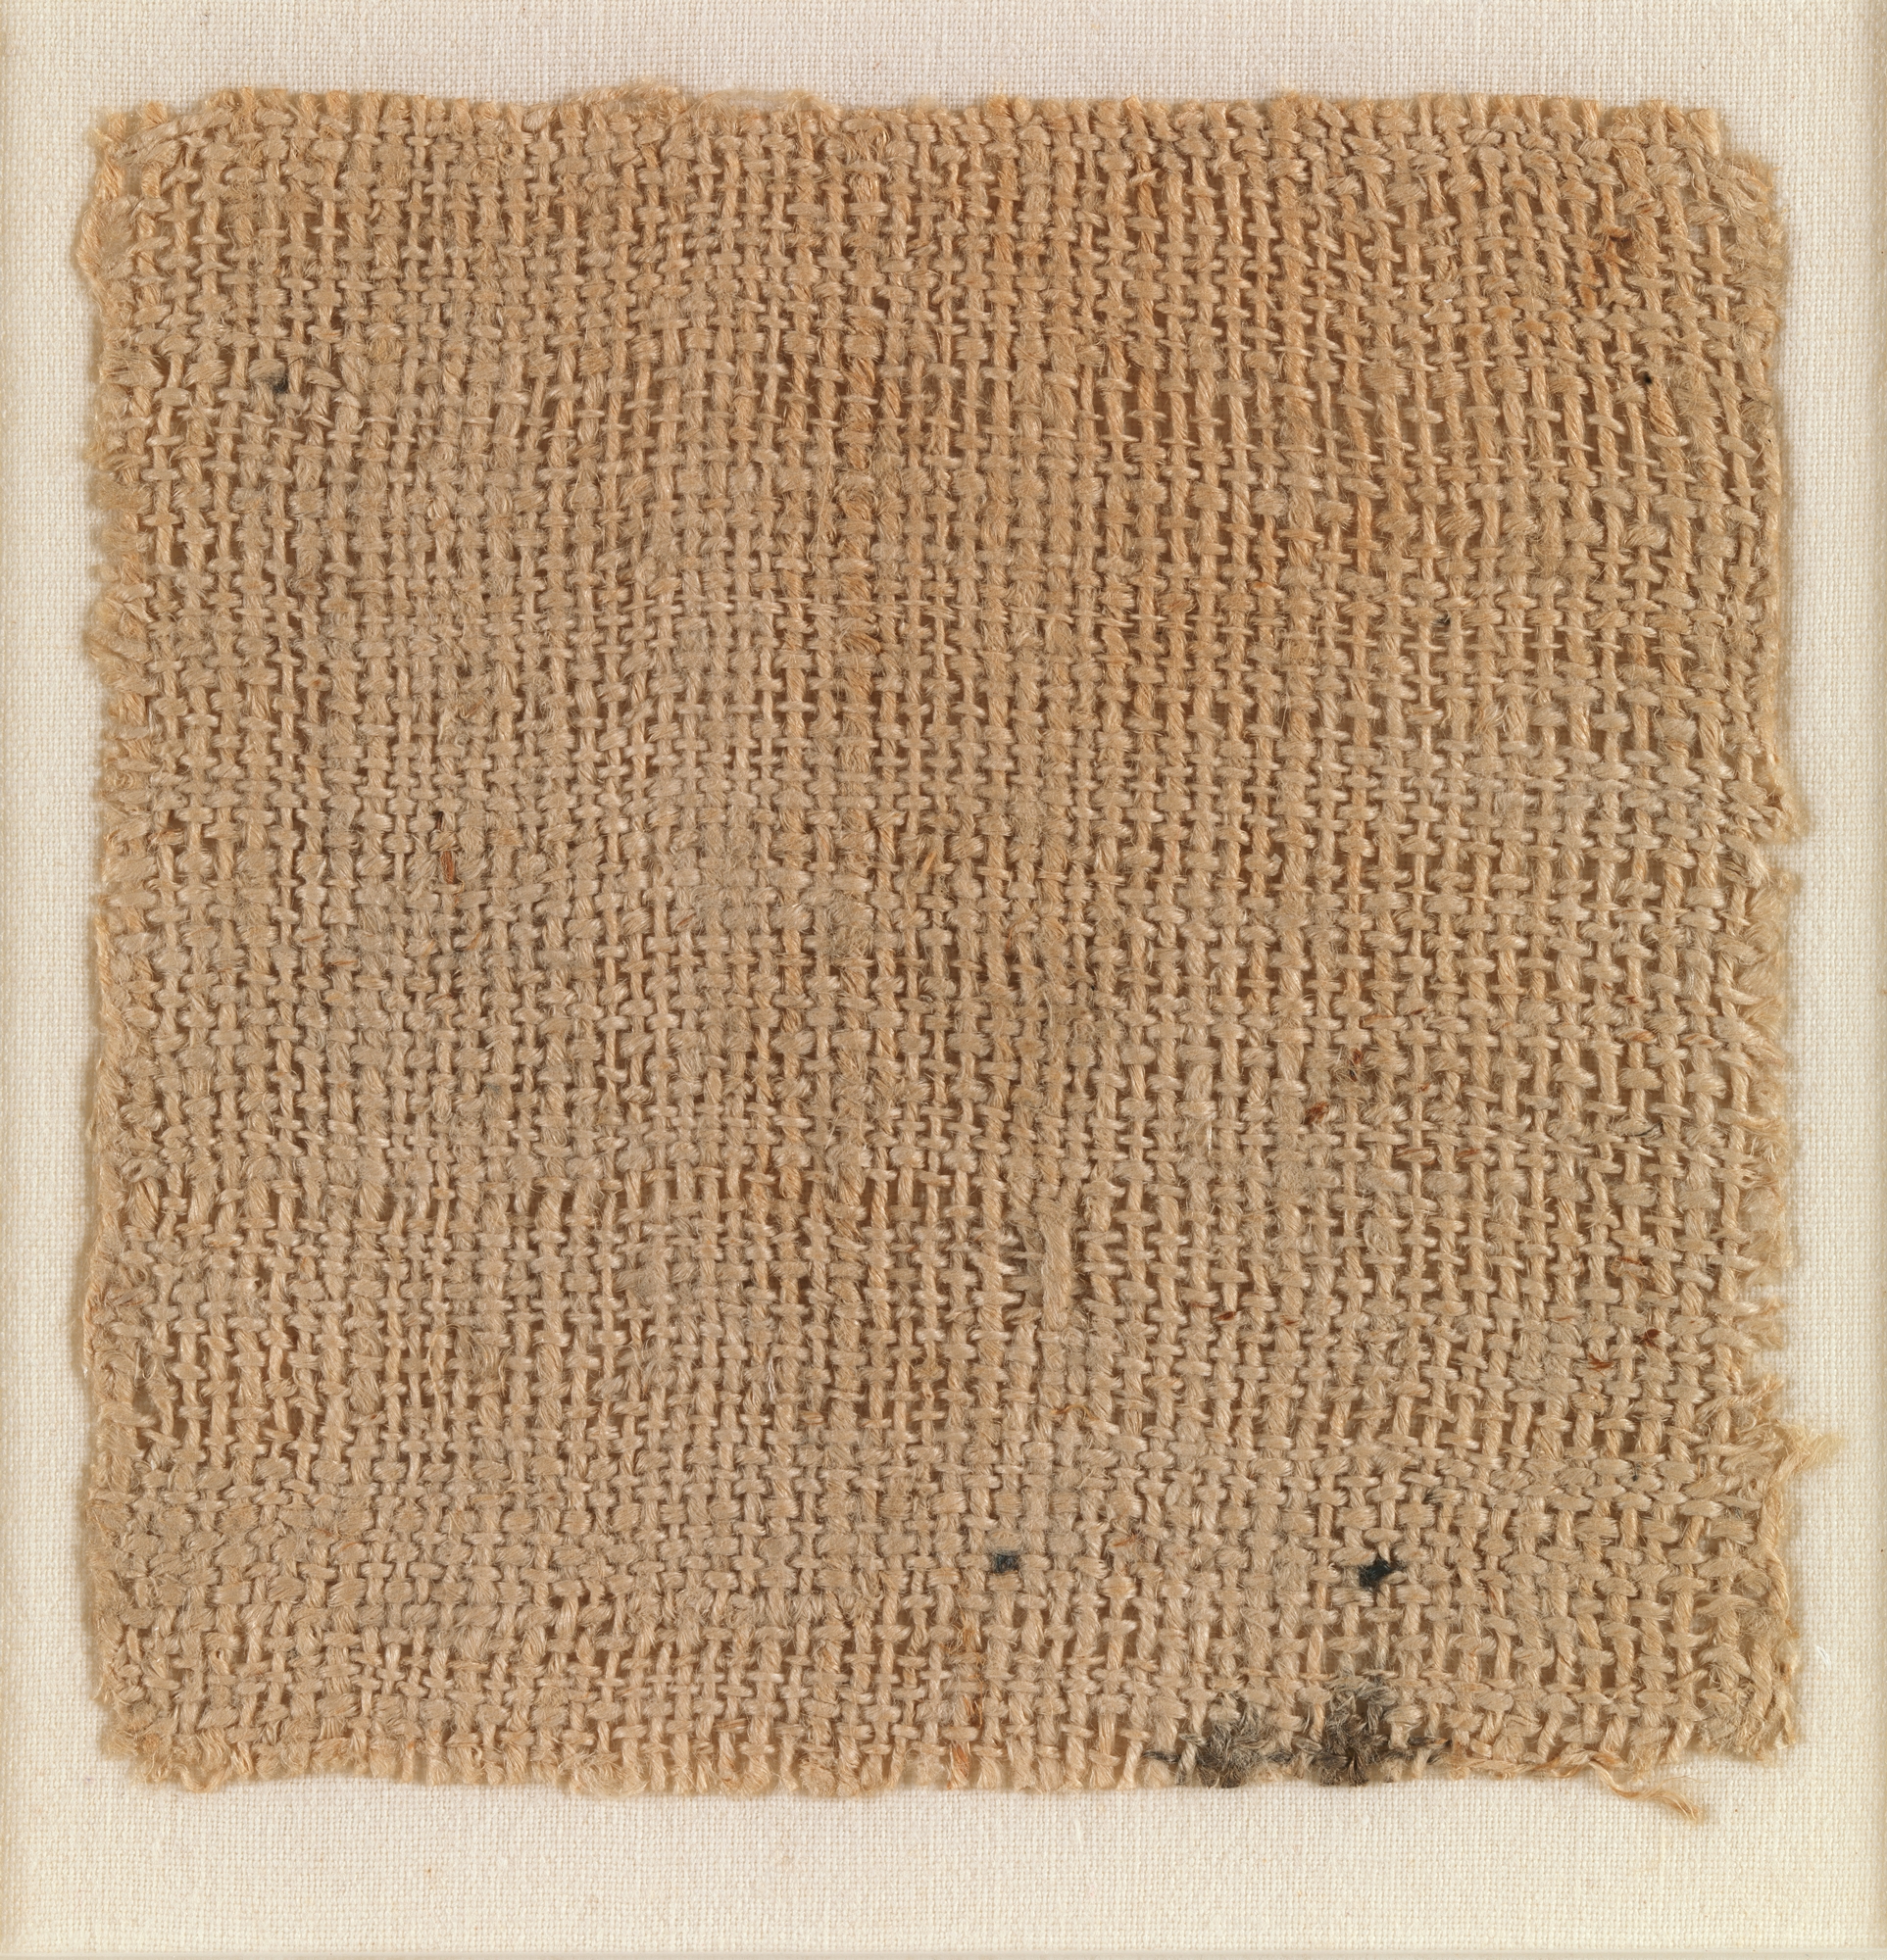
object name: linen mummy cloth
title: Sample of Cloth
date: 390-343 BCE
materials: linen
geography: egypt